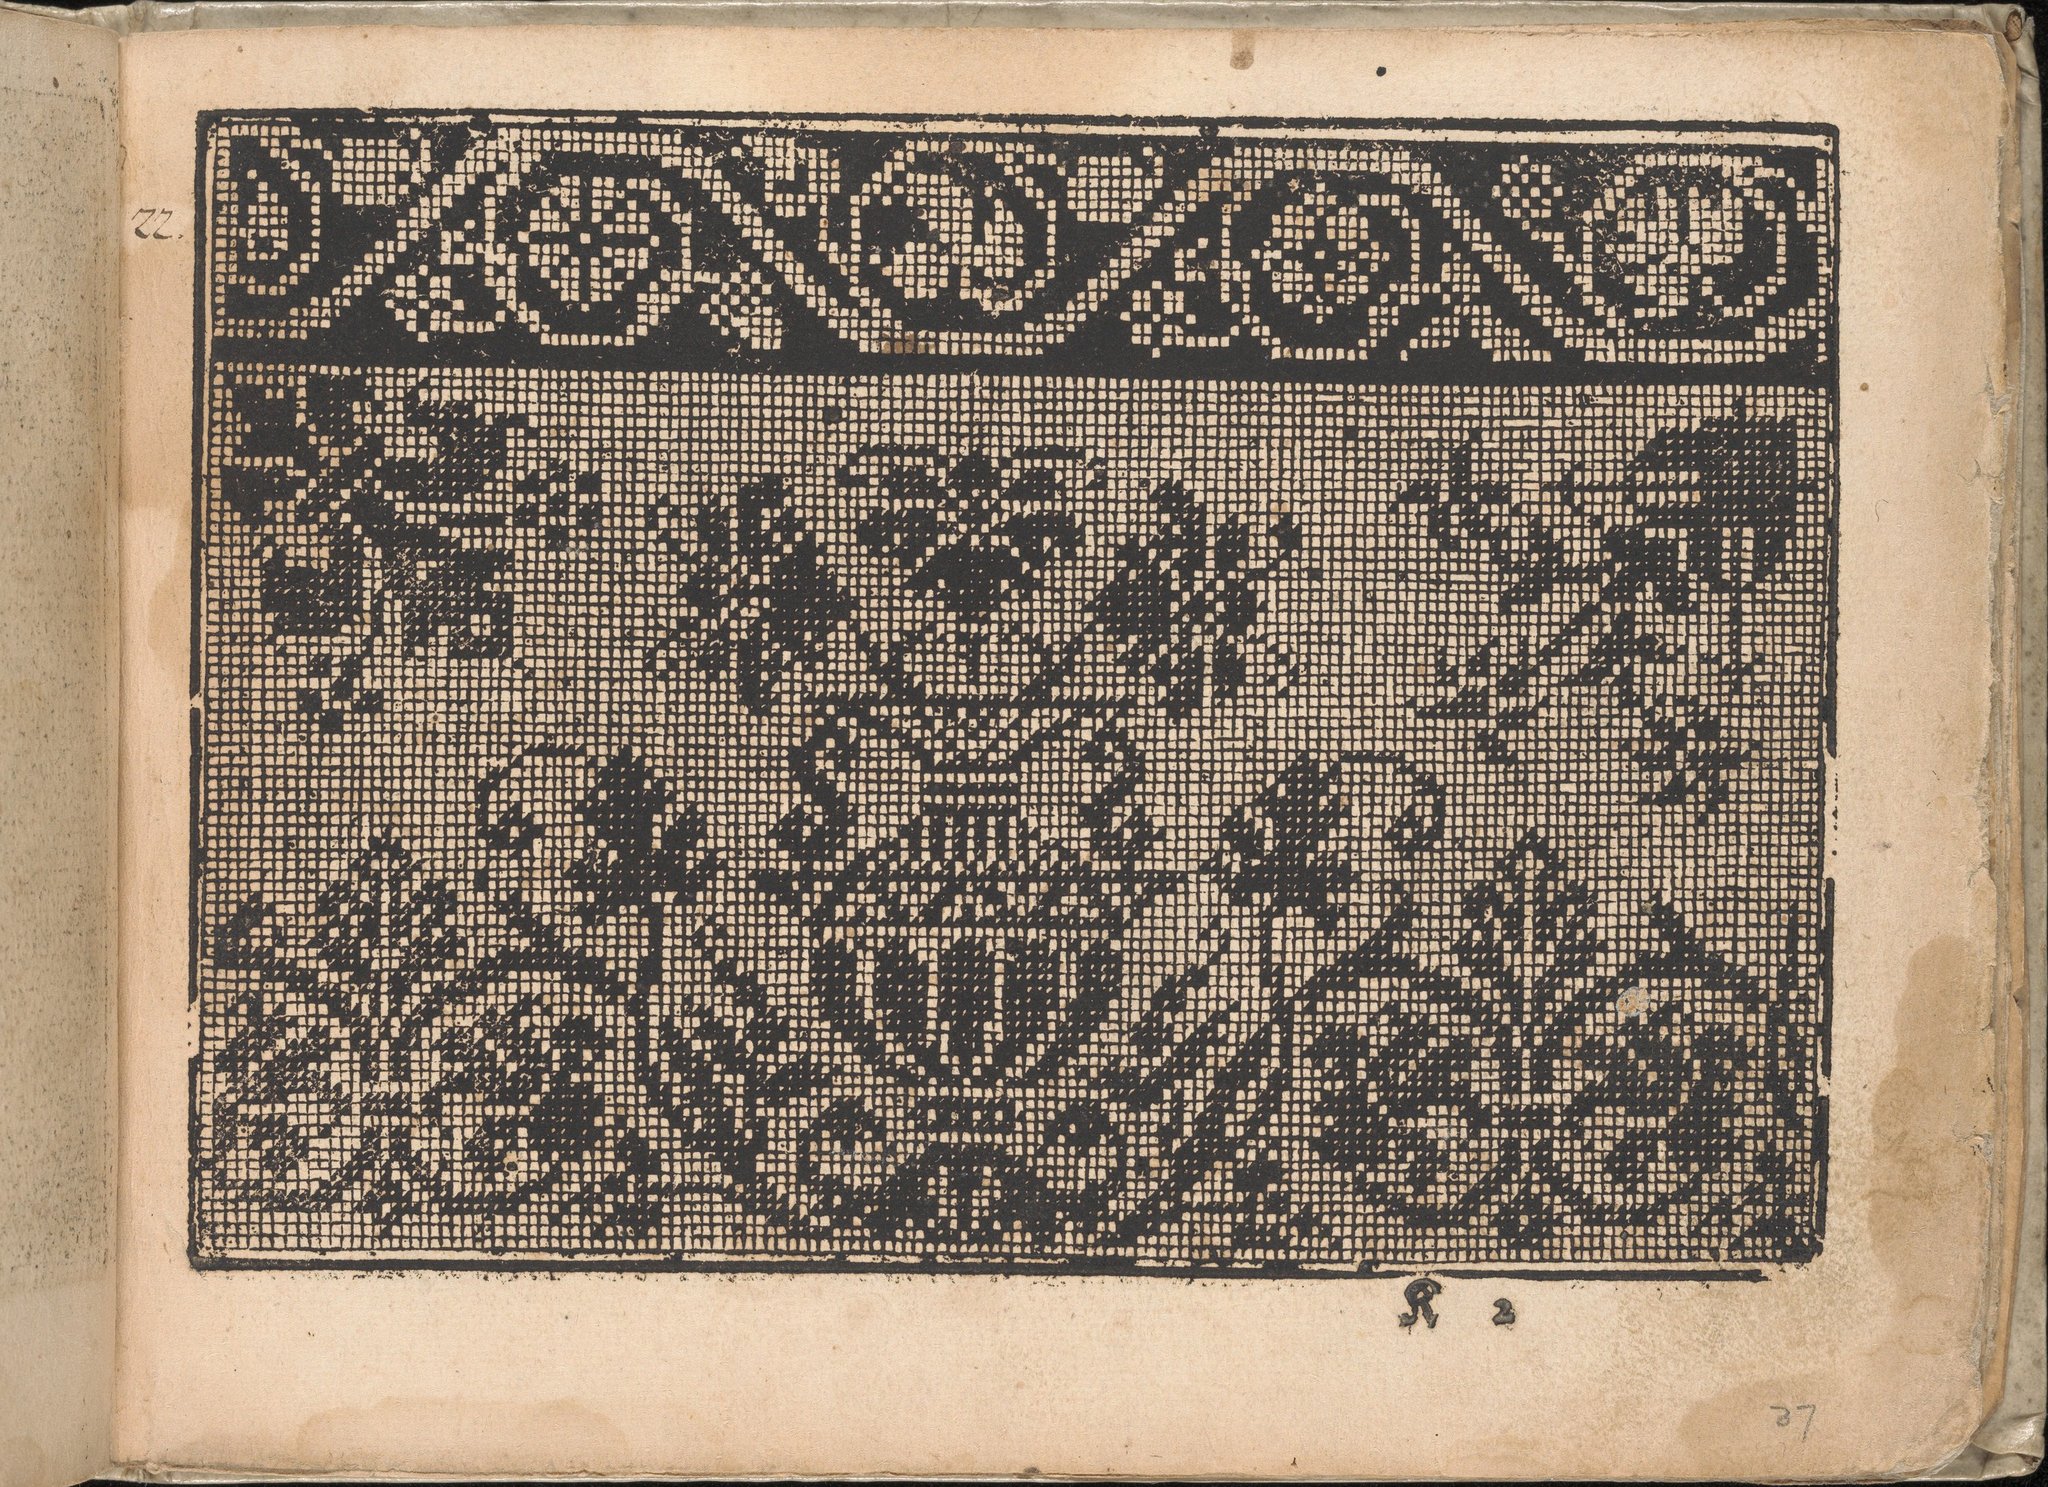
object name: book print ornament architecture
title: Neu künstlich Modelbuch (page 37r)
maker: bernhard jobin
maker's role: publisher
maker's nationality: swiss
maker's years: 1535-1597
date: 1598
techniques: woodcut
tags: flowers,vases